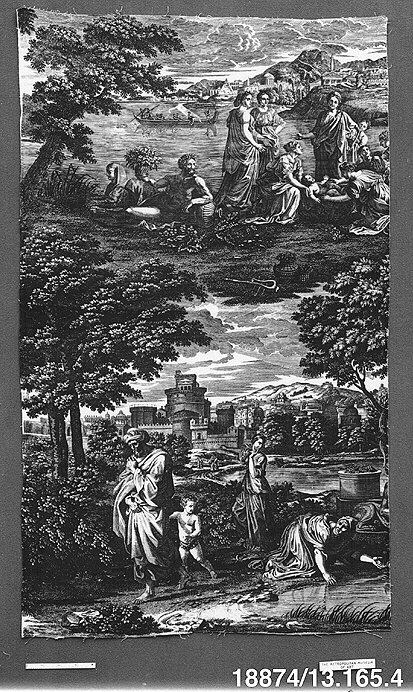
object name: piece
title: Scenes from the Story of Moses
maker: ferdinand favre et cie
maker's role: manufactory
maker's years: 1818-1866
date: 1820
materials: cotton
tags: human figures,buildings,trees,moses